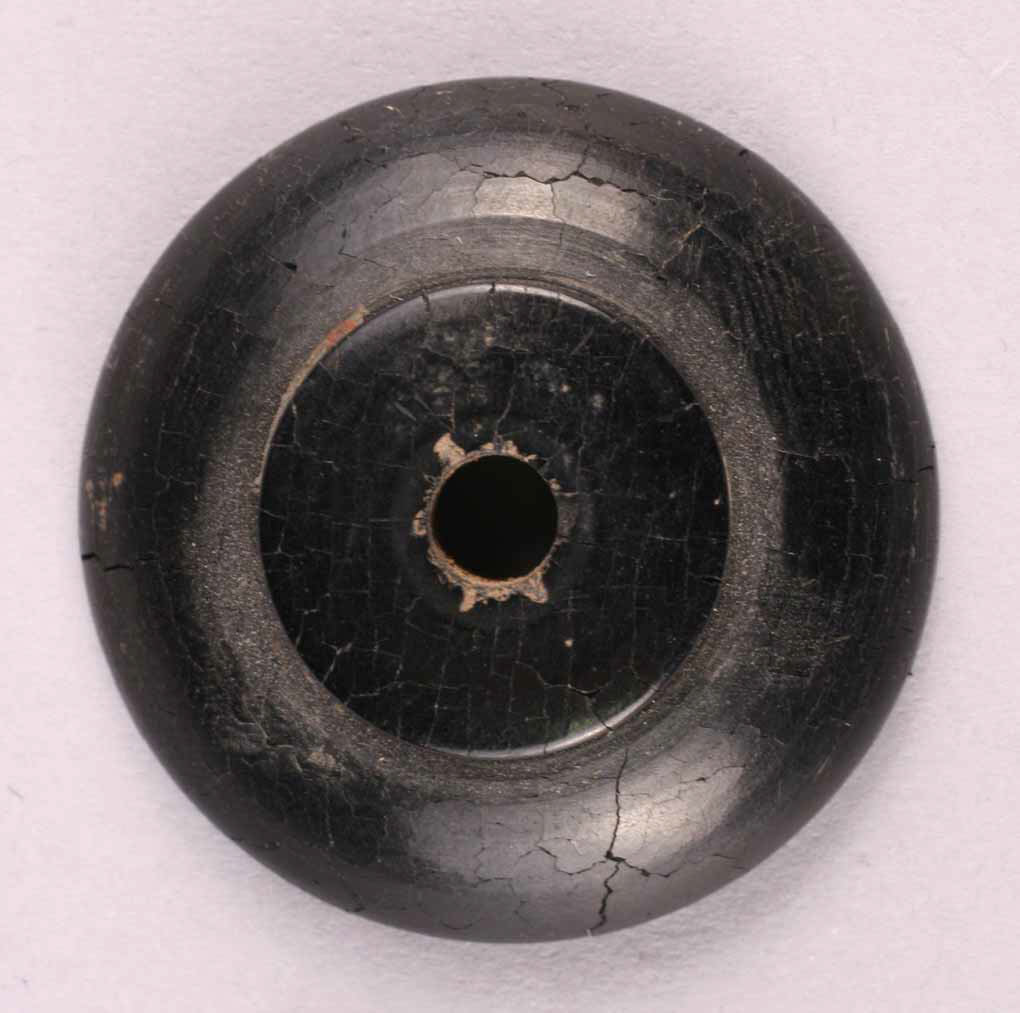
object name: button or bead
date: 801-1100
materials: stone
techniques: carving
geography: iran